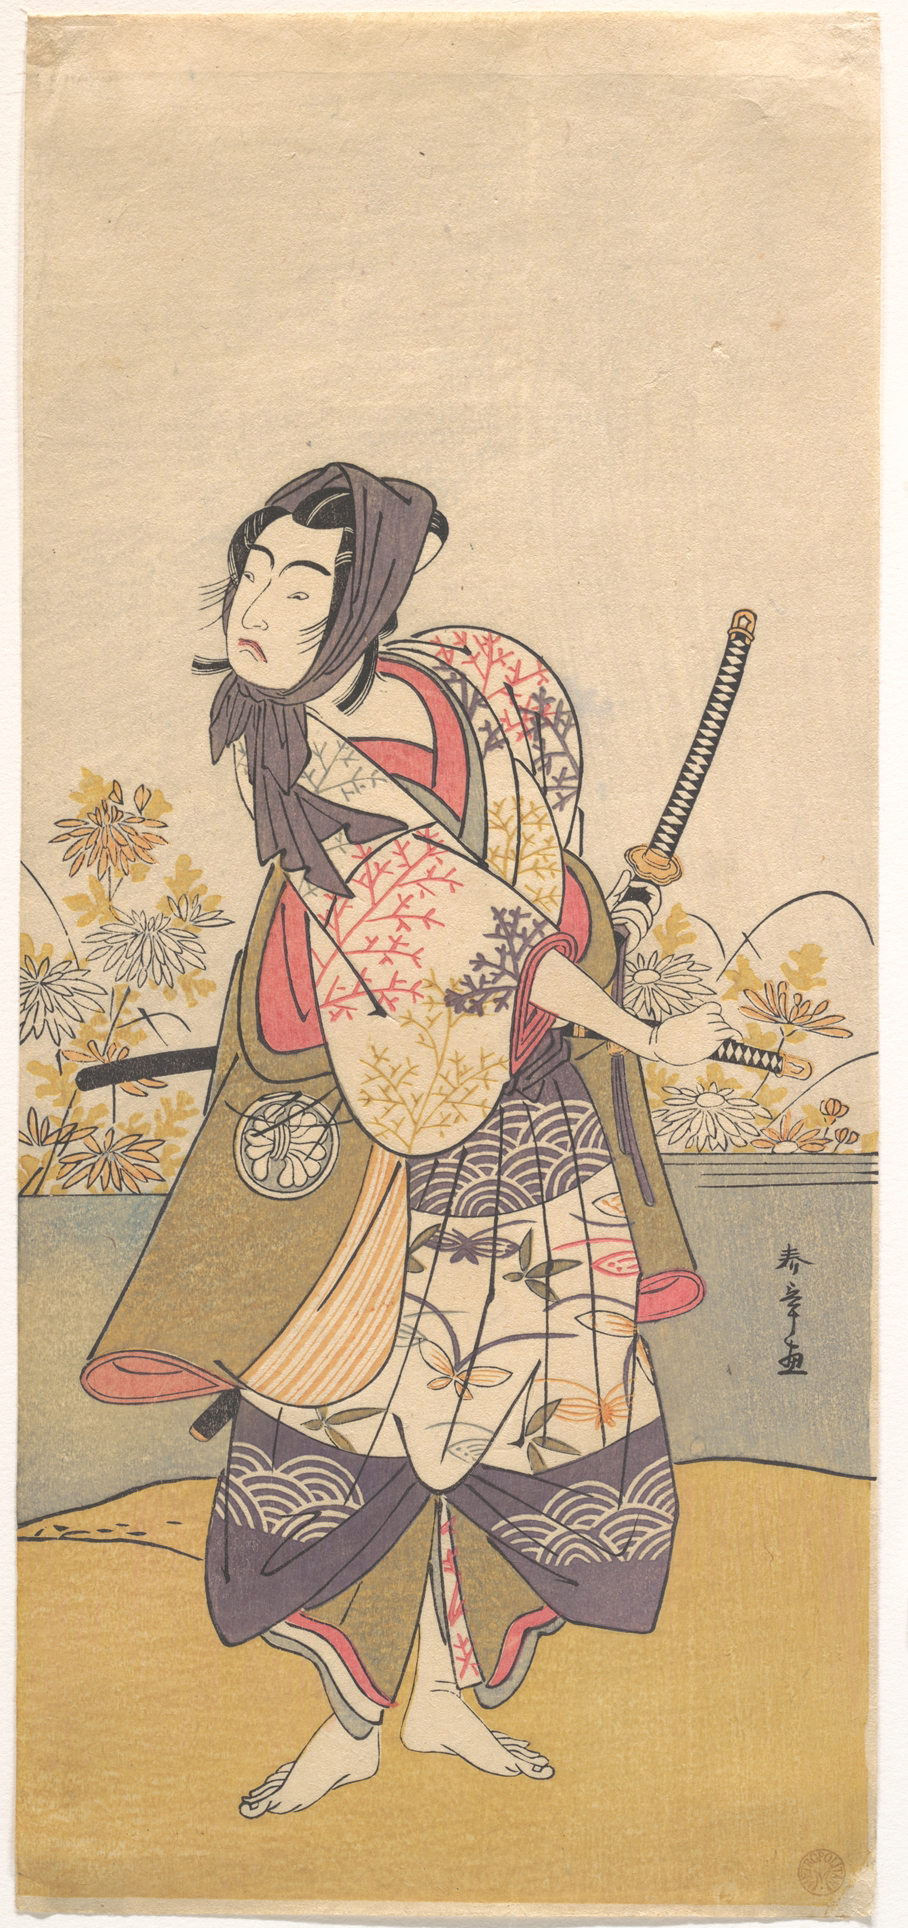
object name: woodblock print nishiki e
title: The Third Segawa Kikunojō in the Role of Soga no Gorō Tokimune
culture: japanese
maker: katsukawa shunshō 勝川春章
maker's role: artist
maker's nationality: japanese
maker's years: 1726-1792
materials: ink, paper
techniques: nishiki e, woodblock print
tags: weapons,actors